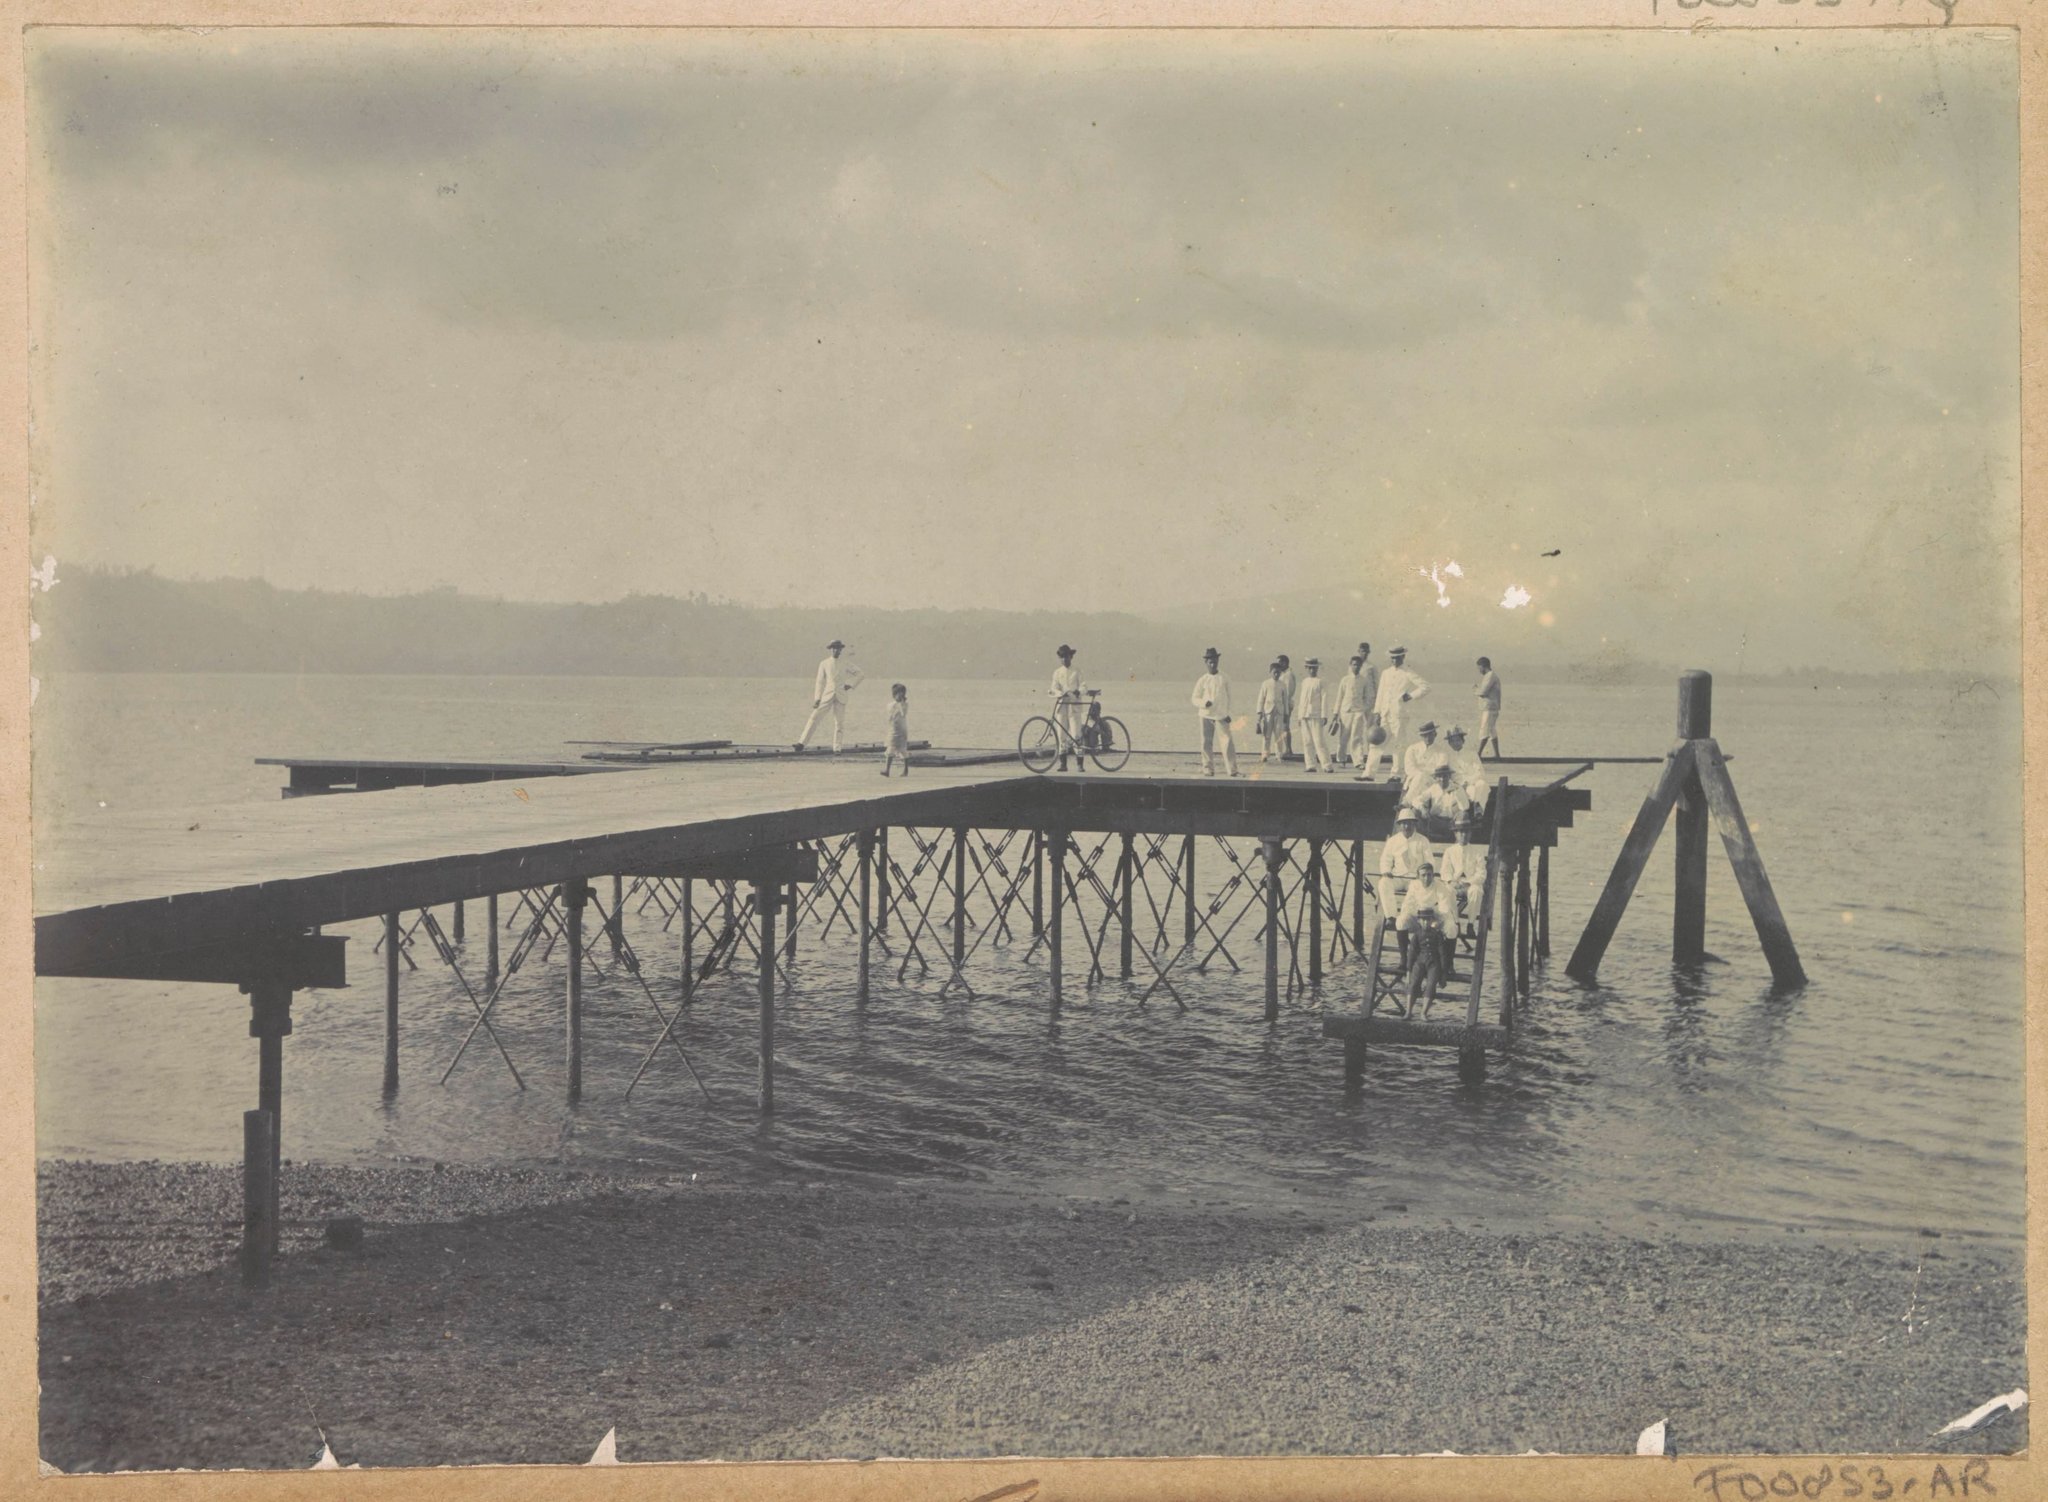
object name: album leaf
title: Plankier aan een water met mannen op Ambon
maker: Anonymous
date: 1900-1920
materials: cardboard, paper, photographic support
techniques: daylight paper print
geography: ambon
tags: bicycle, pier, quay, wharf, dutch east indies, the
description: Onderdeel van Reisalbum met foto's van Ambon.